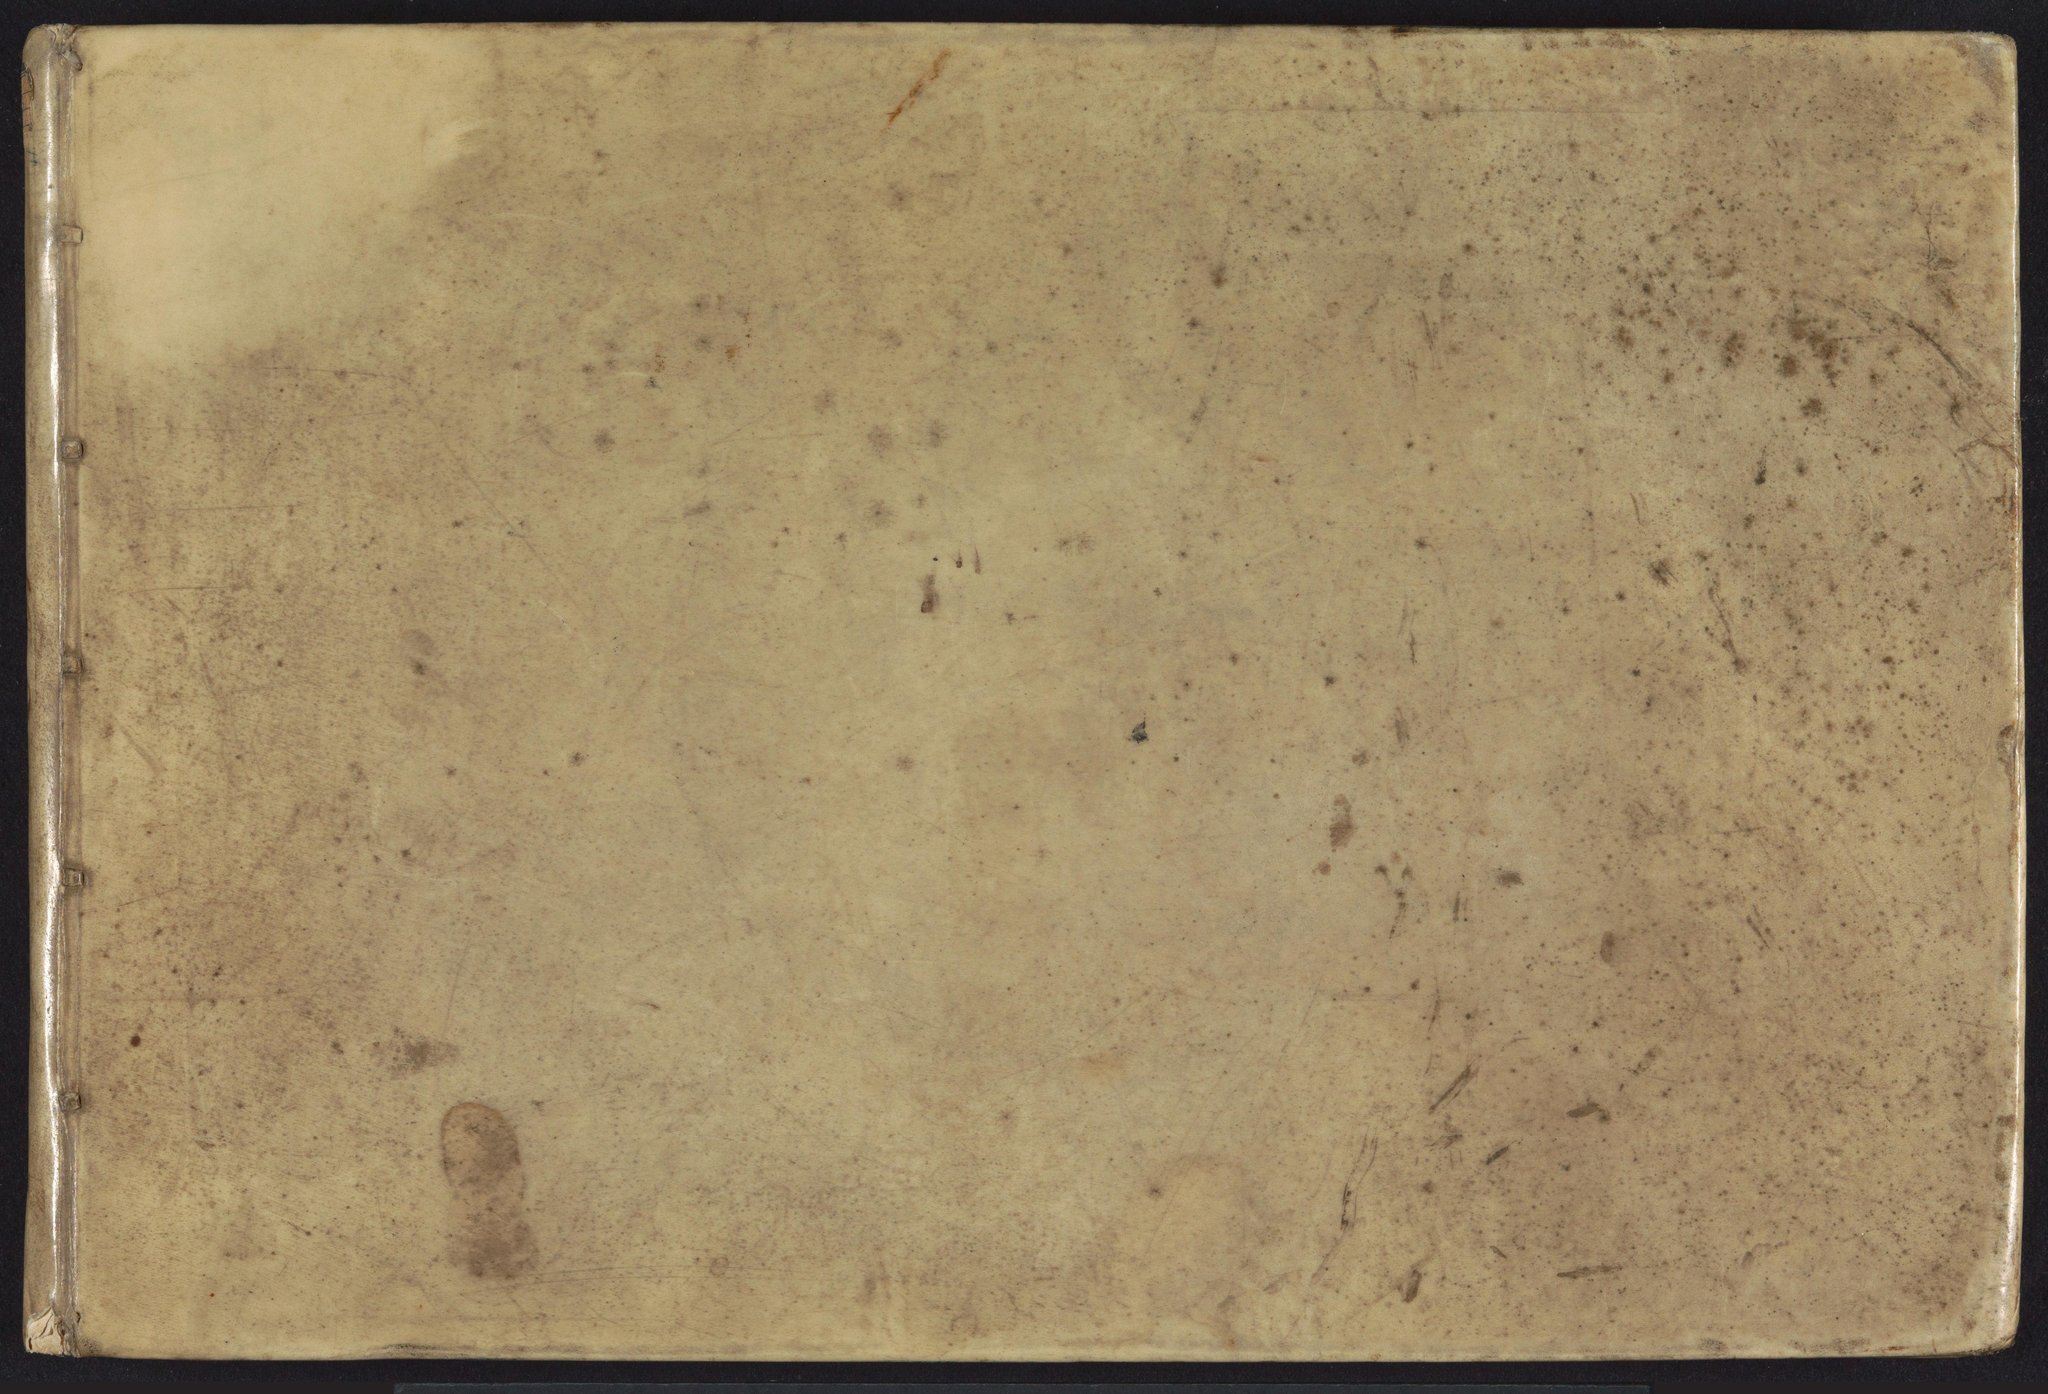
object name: prentrecueil, prentenalbum, prentalbum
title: Album met voorstellingen van paleizen, fonteinen, sculpturen, triomfbogen, piramides en andere monumenten te Rome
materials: paper, parchment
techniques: bookbinding, engraving, etching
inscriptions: number: ‘253’, number: ‘No. 9’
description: Album met 141 prenten op 113 albumbladen. Het album bevat zeven verschillende prentseries met voorstellingen van paleizen, fonteinen, sculpturen, triomfbogen, piramides en andere monumenten te Rome. Achterin een serie met voorstellingen van een triomftocht. Een perkamentenband met voorin drie schutbladen waarvan twee zijn voorzien van een handgeschreven index in pen in bruin, achterin drie blanco schutbladen. Na folio 95 ontbreken vier bladen.